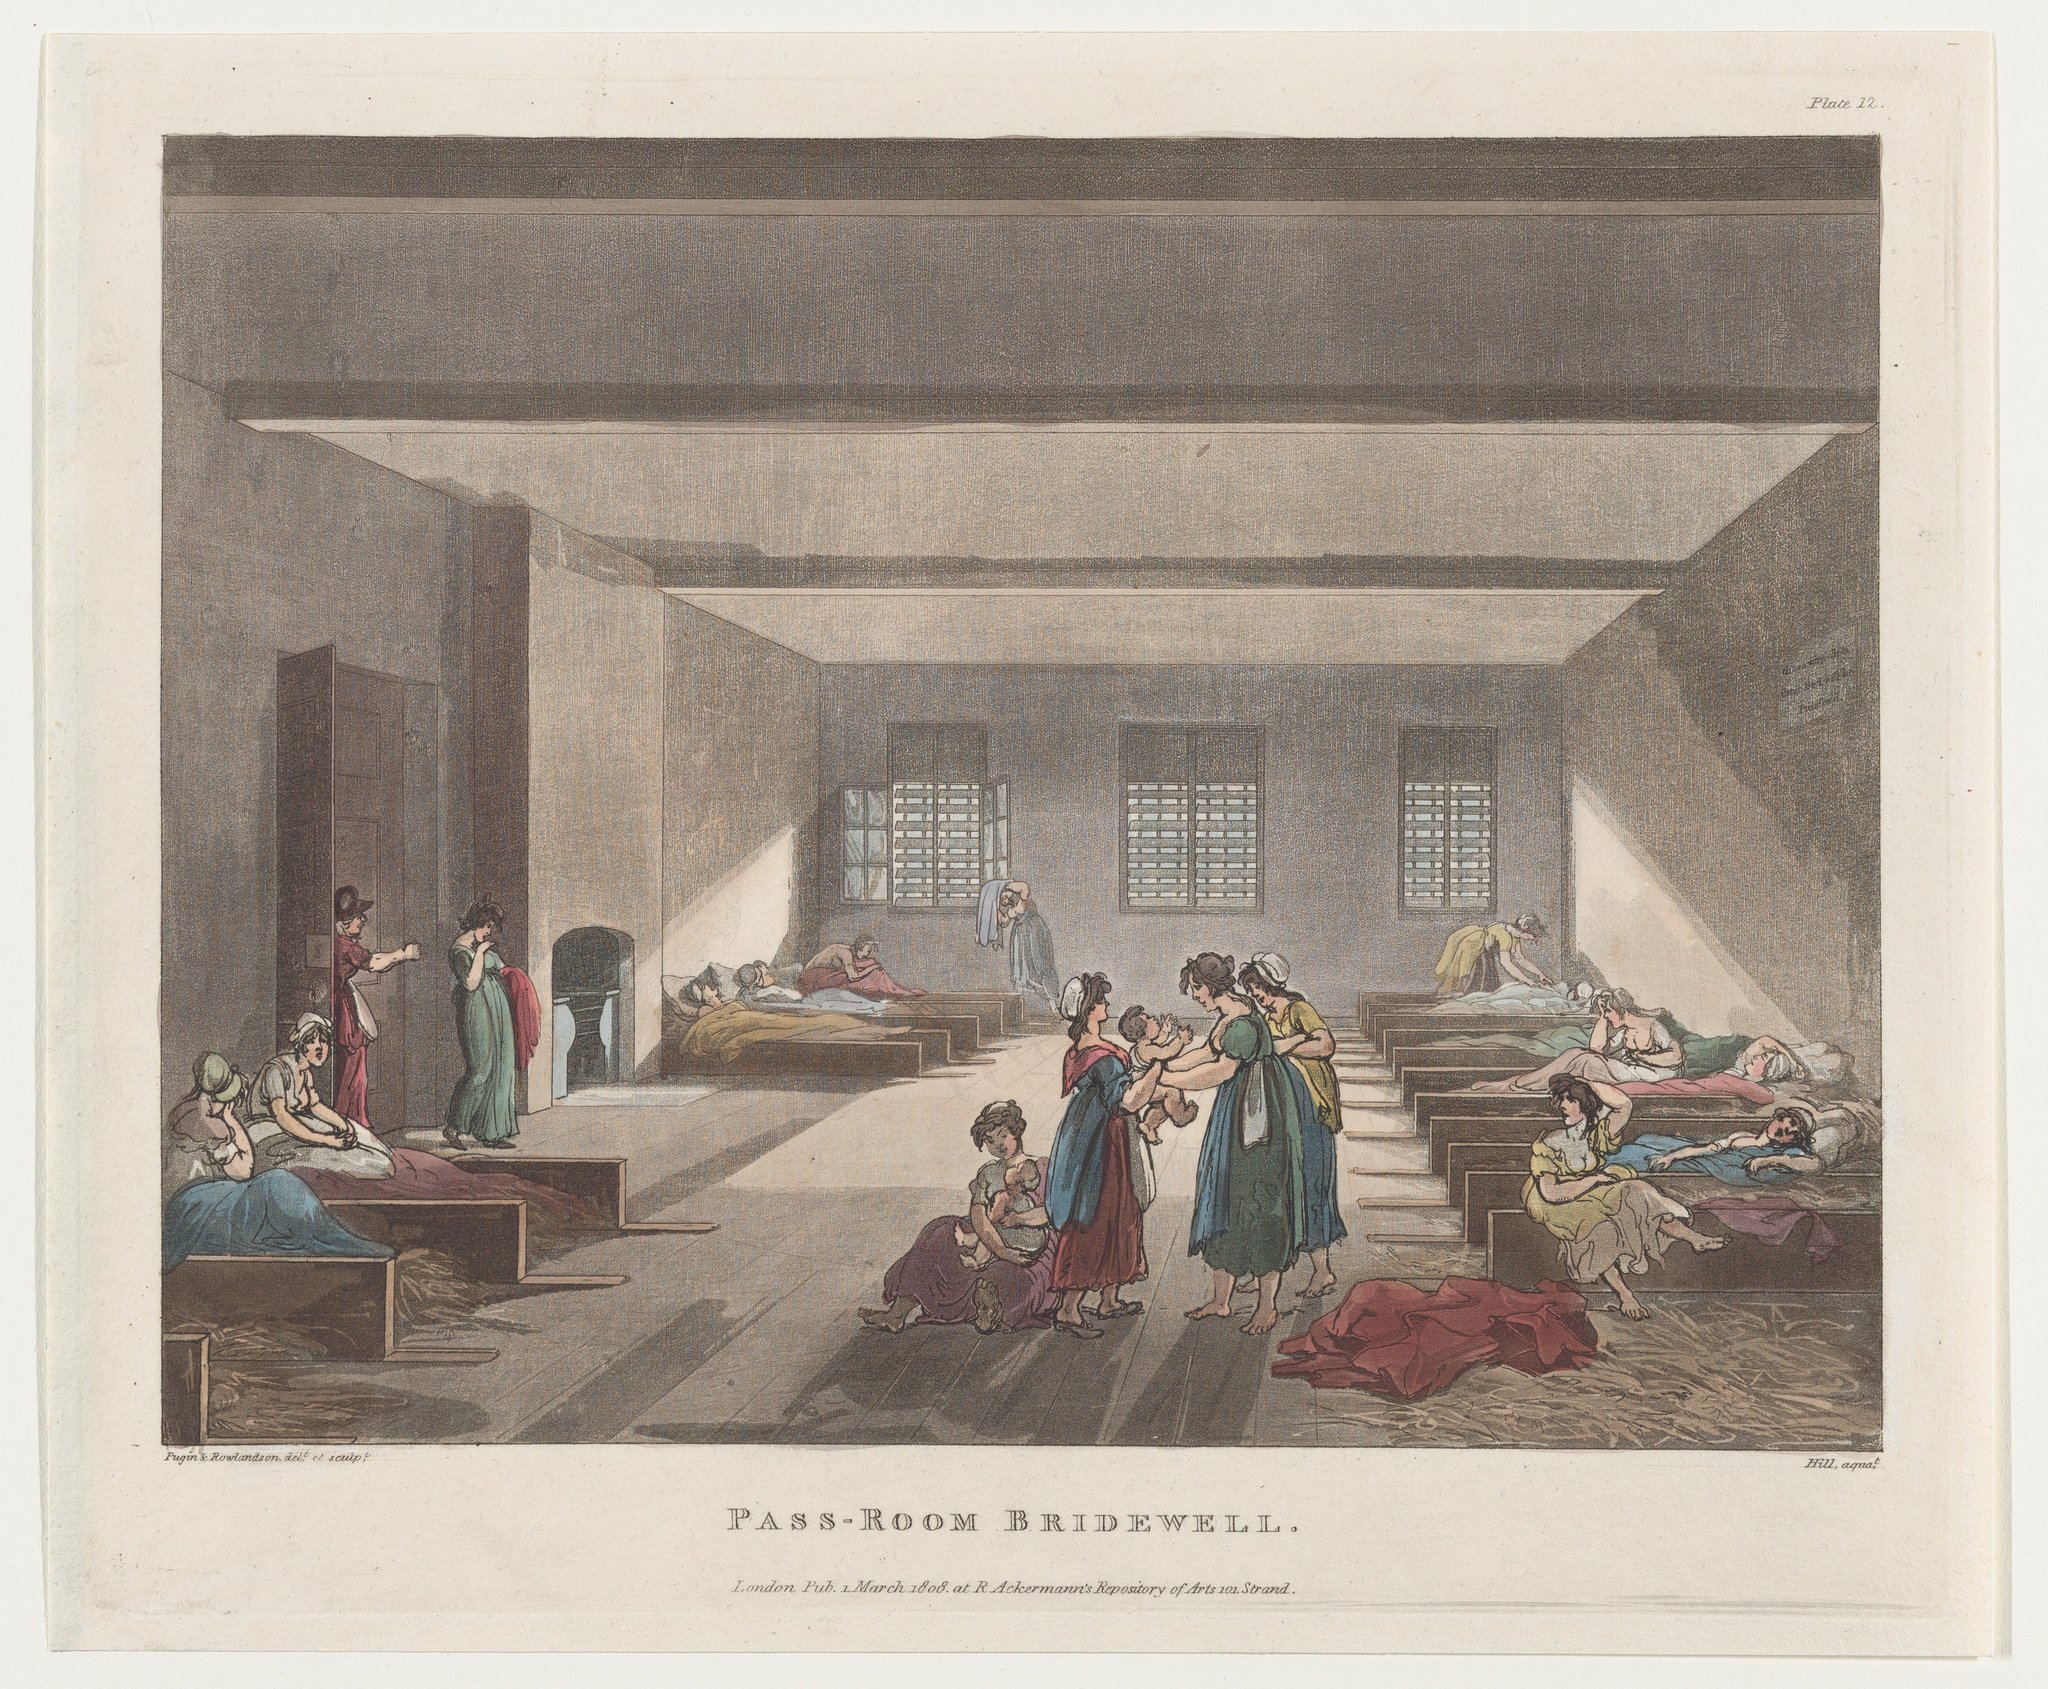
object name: print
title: Pass-Room Bridewell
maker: thomas rowlandson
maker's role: artist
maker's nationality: british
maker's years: 1757-1827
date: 1808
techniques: aquatint, etching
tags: women,beds